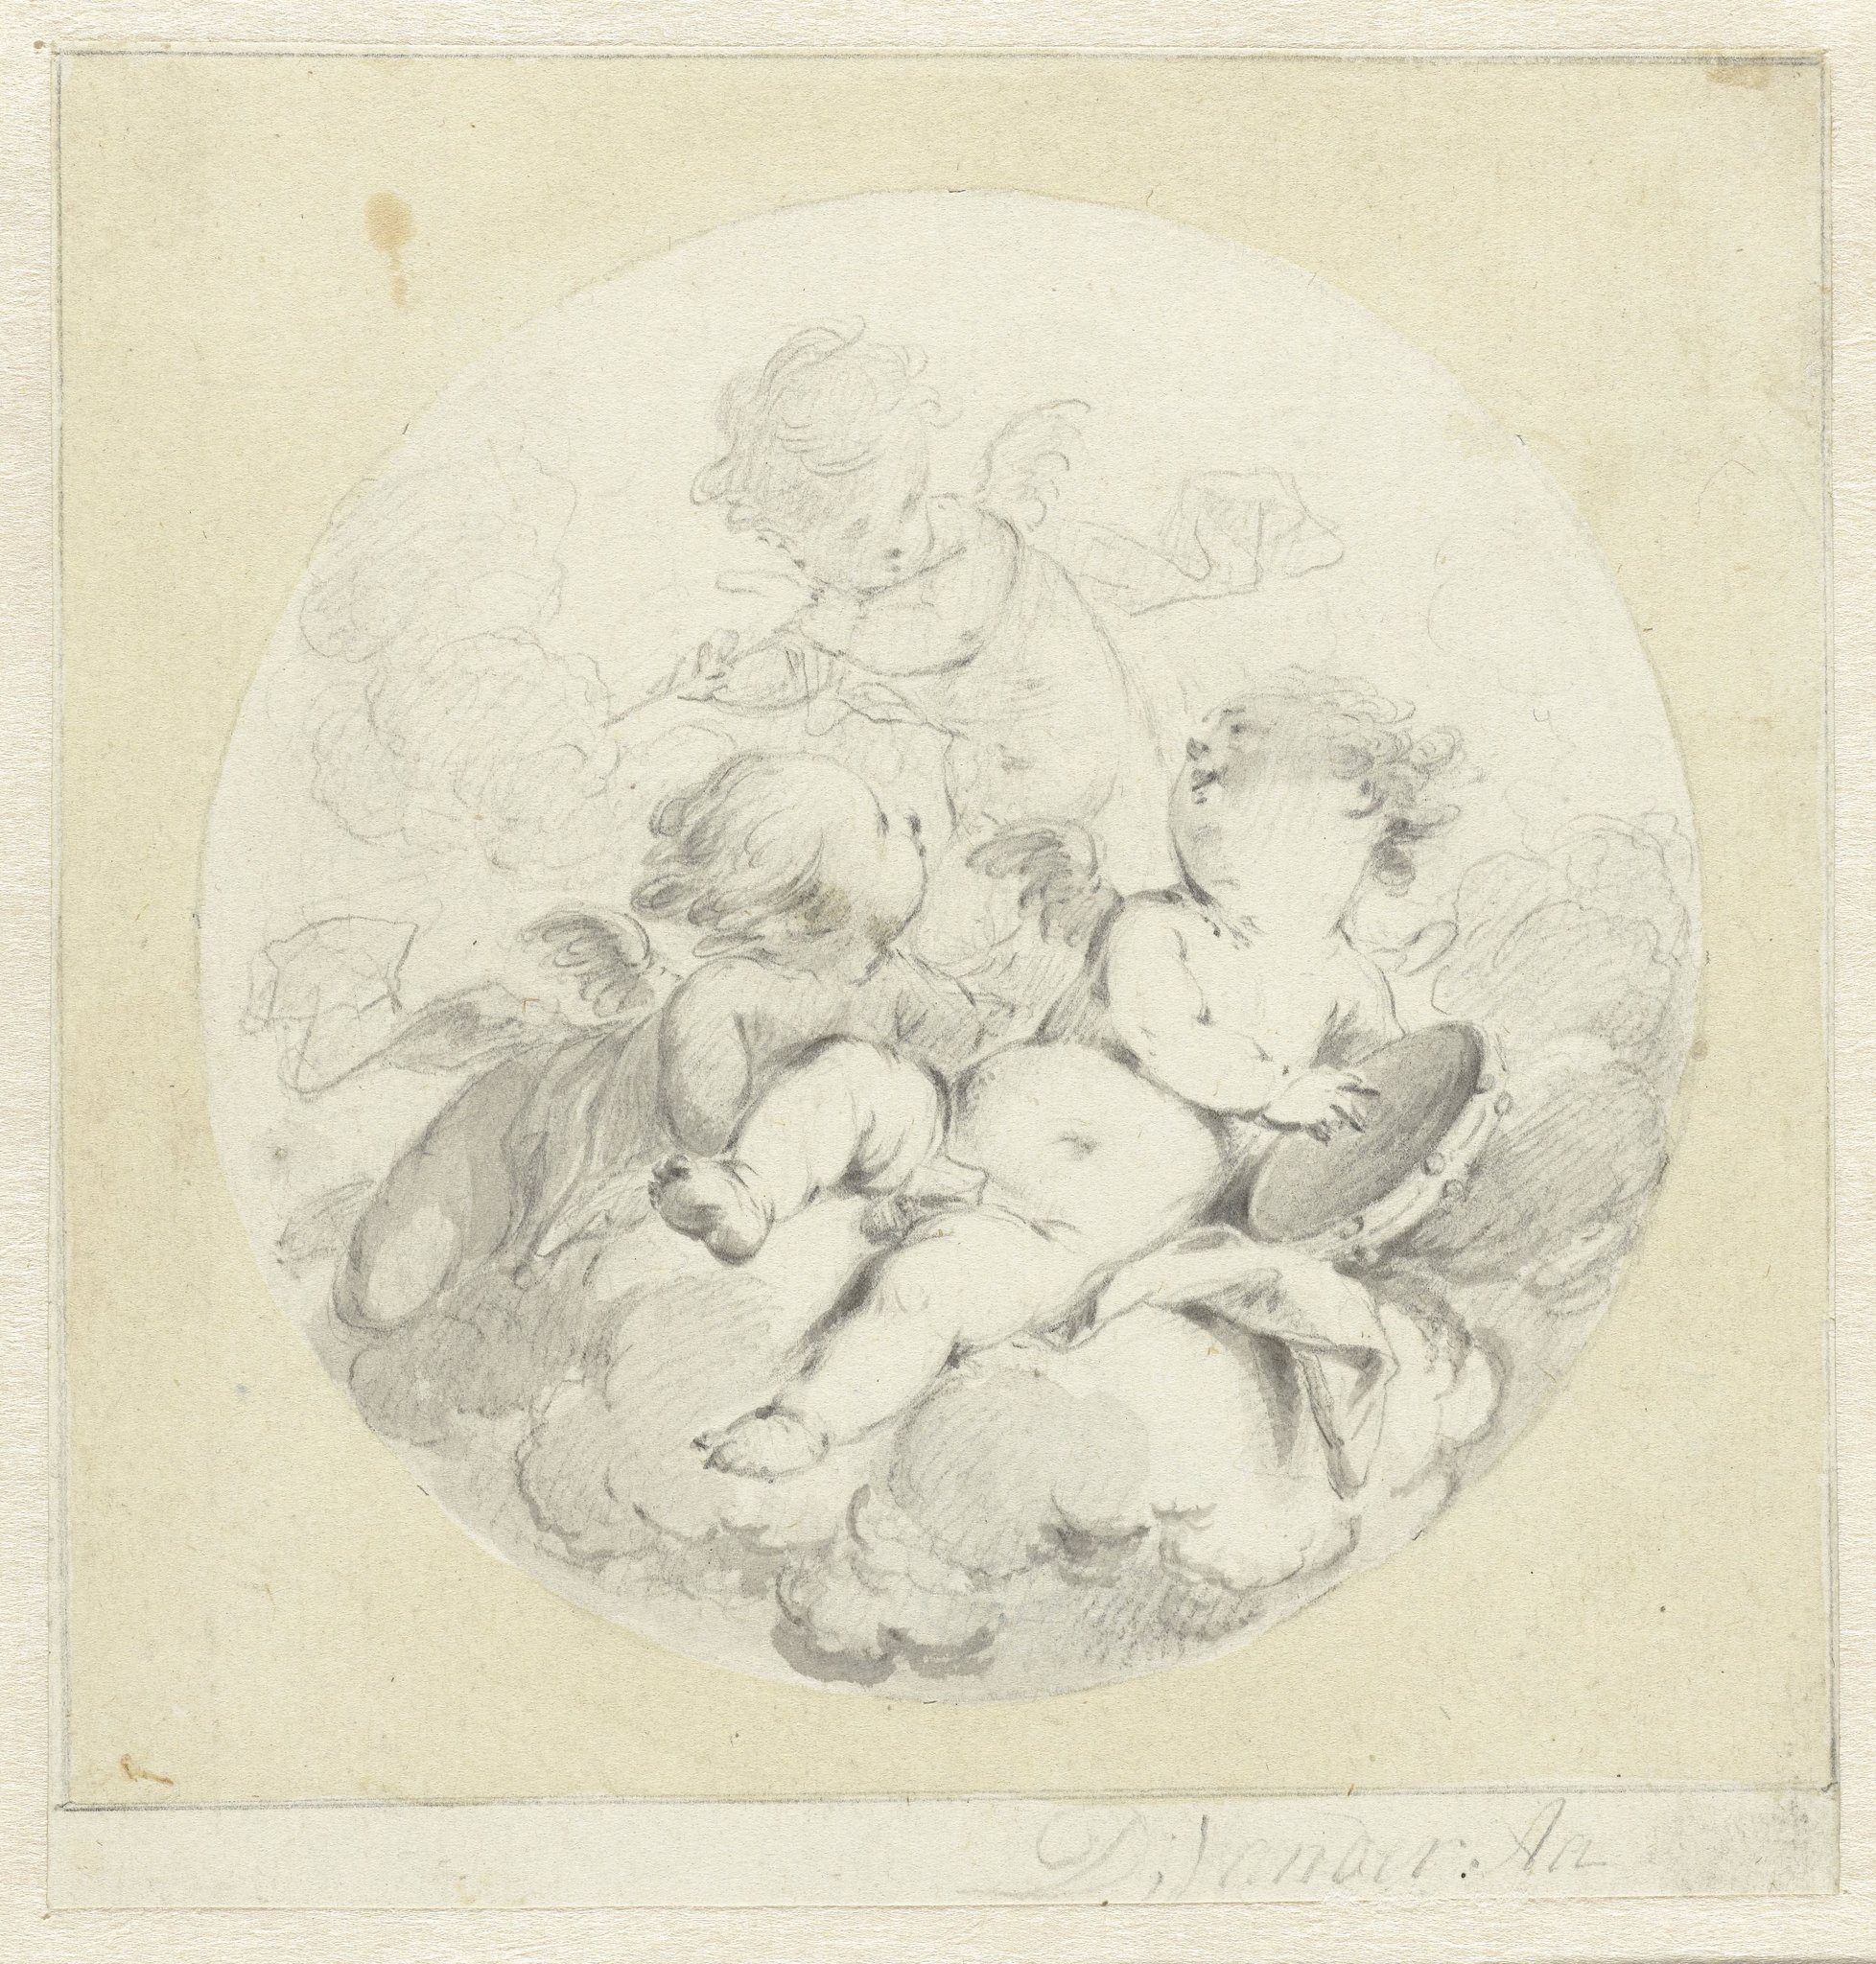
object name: drawing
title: Musicerende geniën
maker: dirk van der aa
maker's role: draughtsman, painter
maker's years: 1731-1809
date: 1741-1809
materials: paper, pencil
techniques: brush